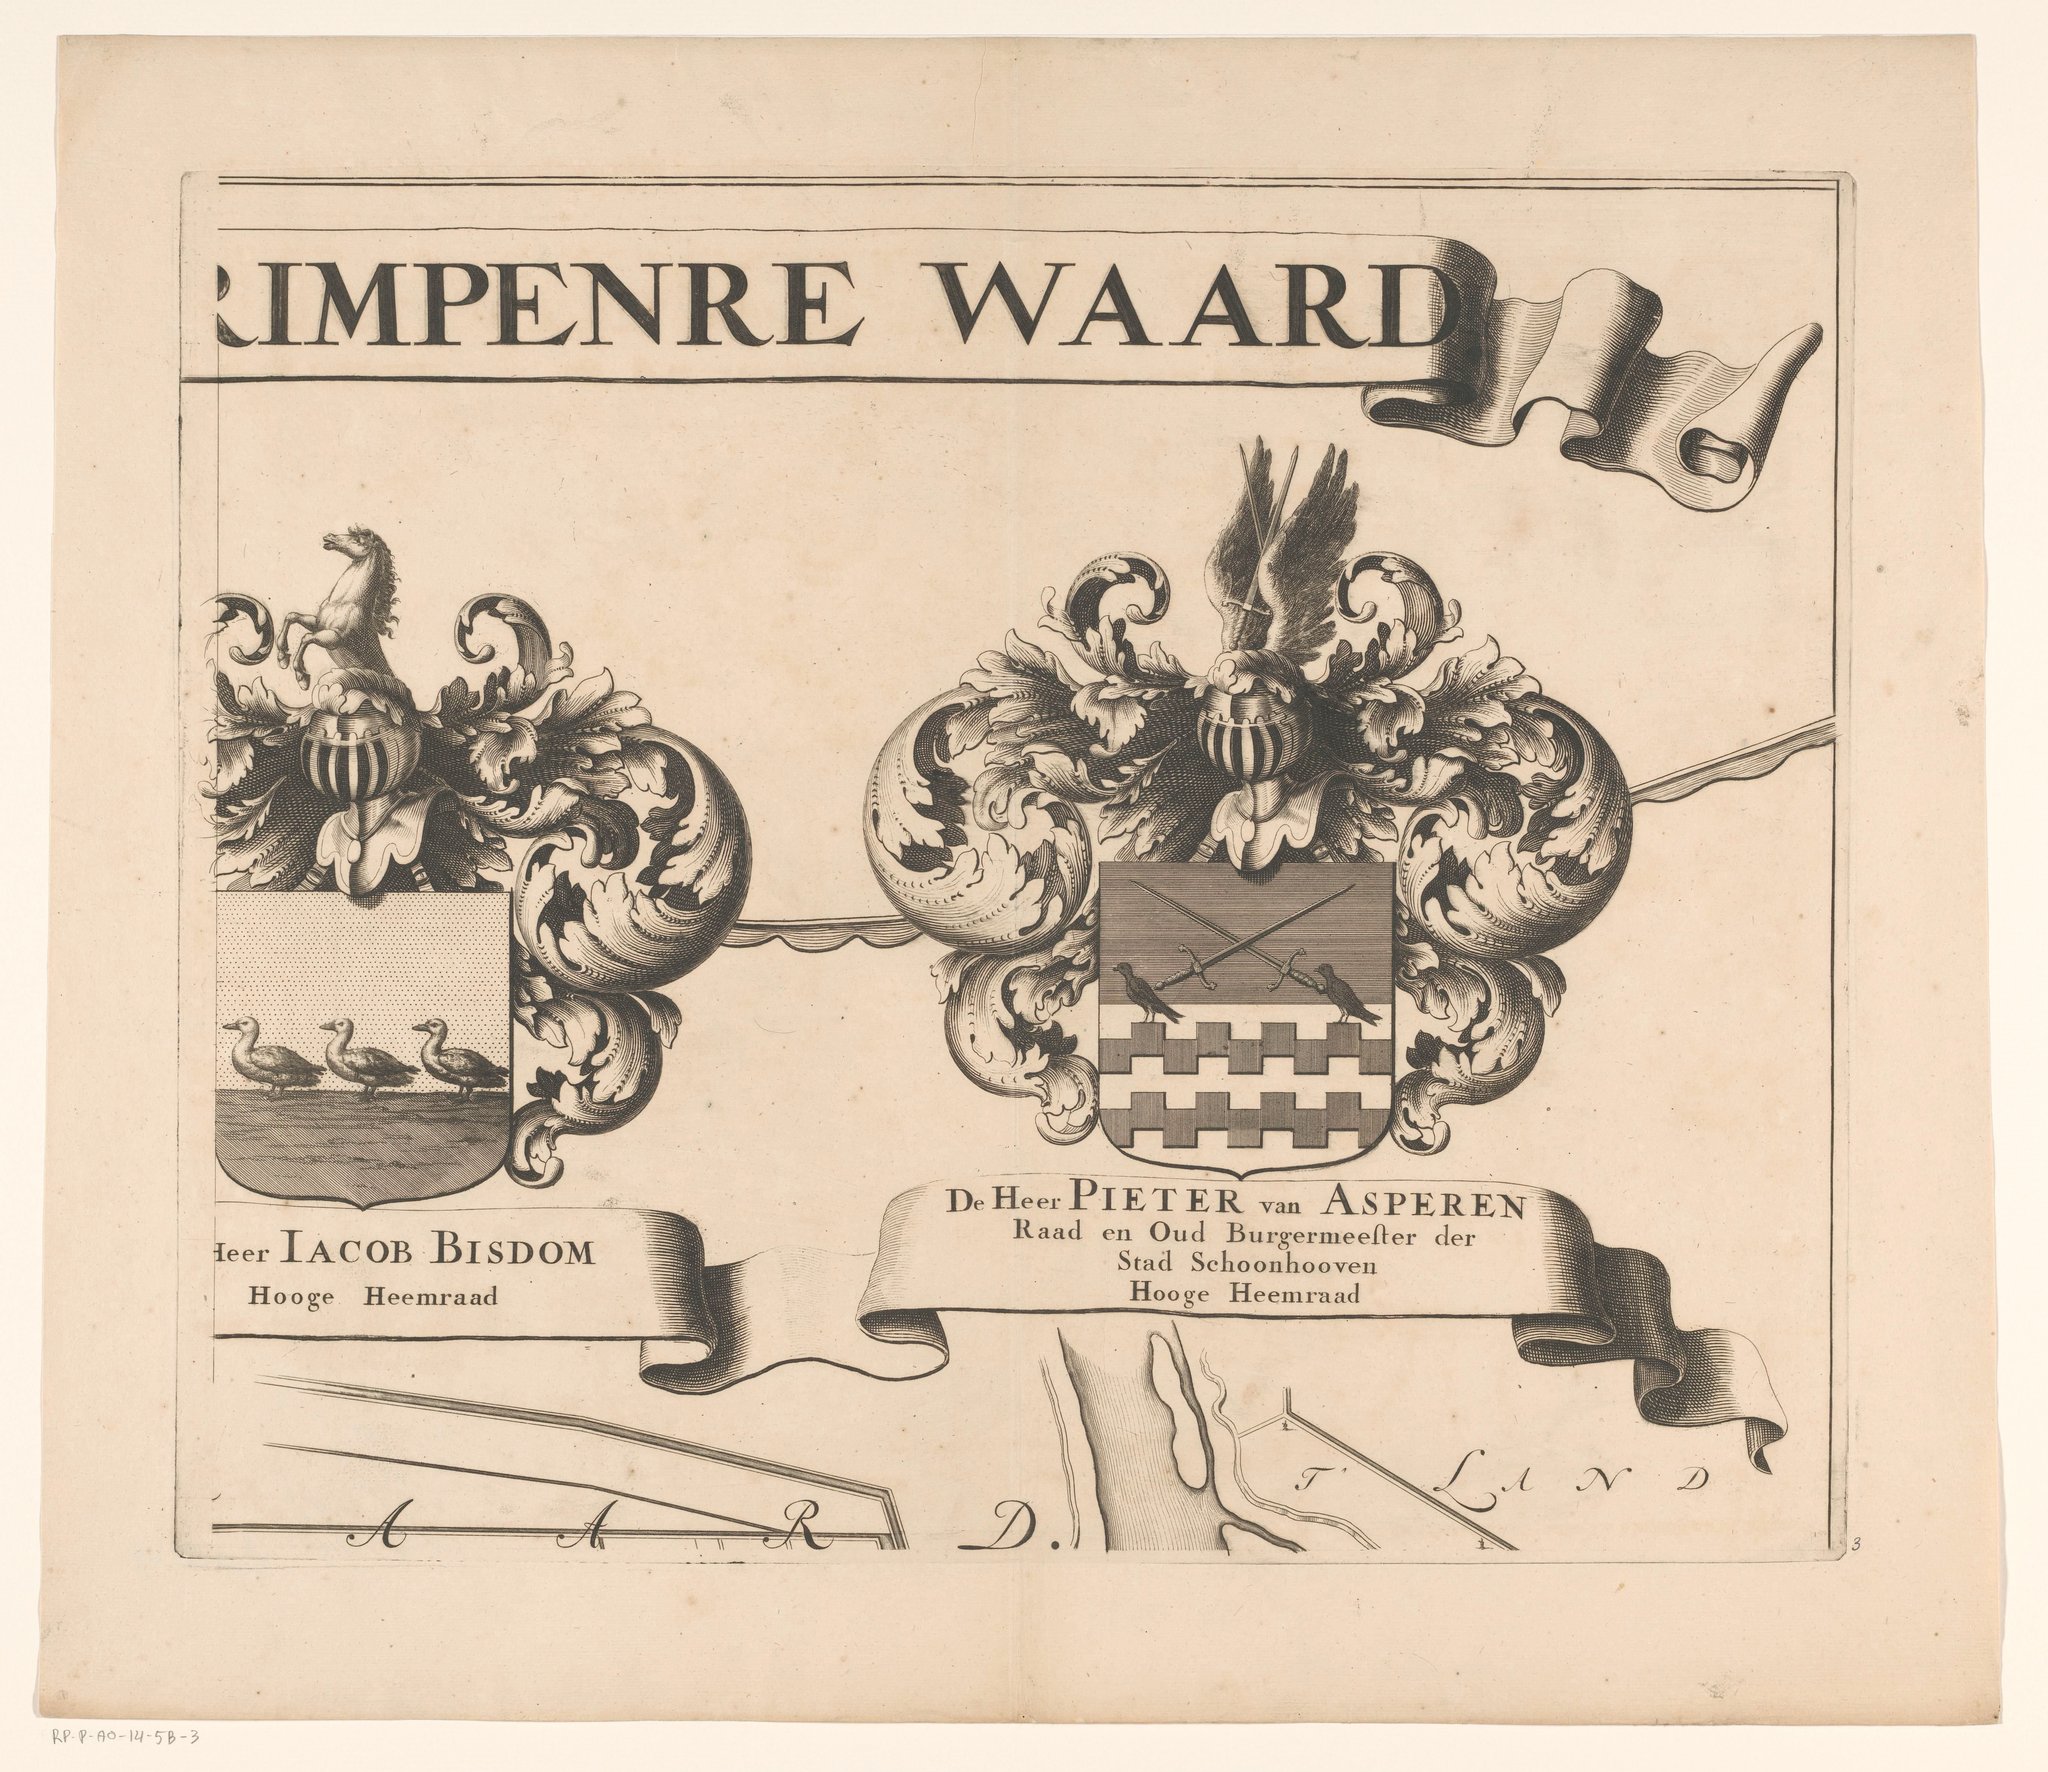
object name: map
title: Kaart van het Hoogheemraadschap van de Krimpenerwaard (deel wapenrand)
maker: johannes leupenius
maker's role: draughtsman, painter, print maker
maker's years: 1646-1693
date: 1683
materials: paper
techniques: engraving, etching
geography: amsterdam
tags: maps of separate countries or regions, armorial bearing, heraldry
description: Deel van de wapenrand van de eerste druk van 'Het Hooge Heemraadschap vande Crimpenre Waard', een wandkaart (bestaande uit een zesdelige kaart en een wapenrand) van het Hoogheemraadschap van de Krimpenerwaard.